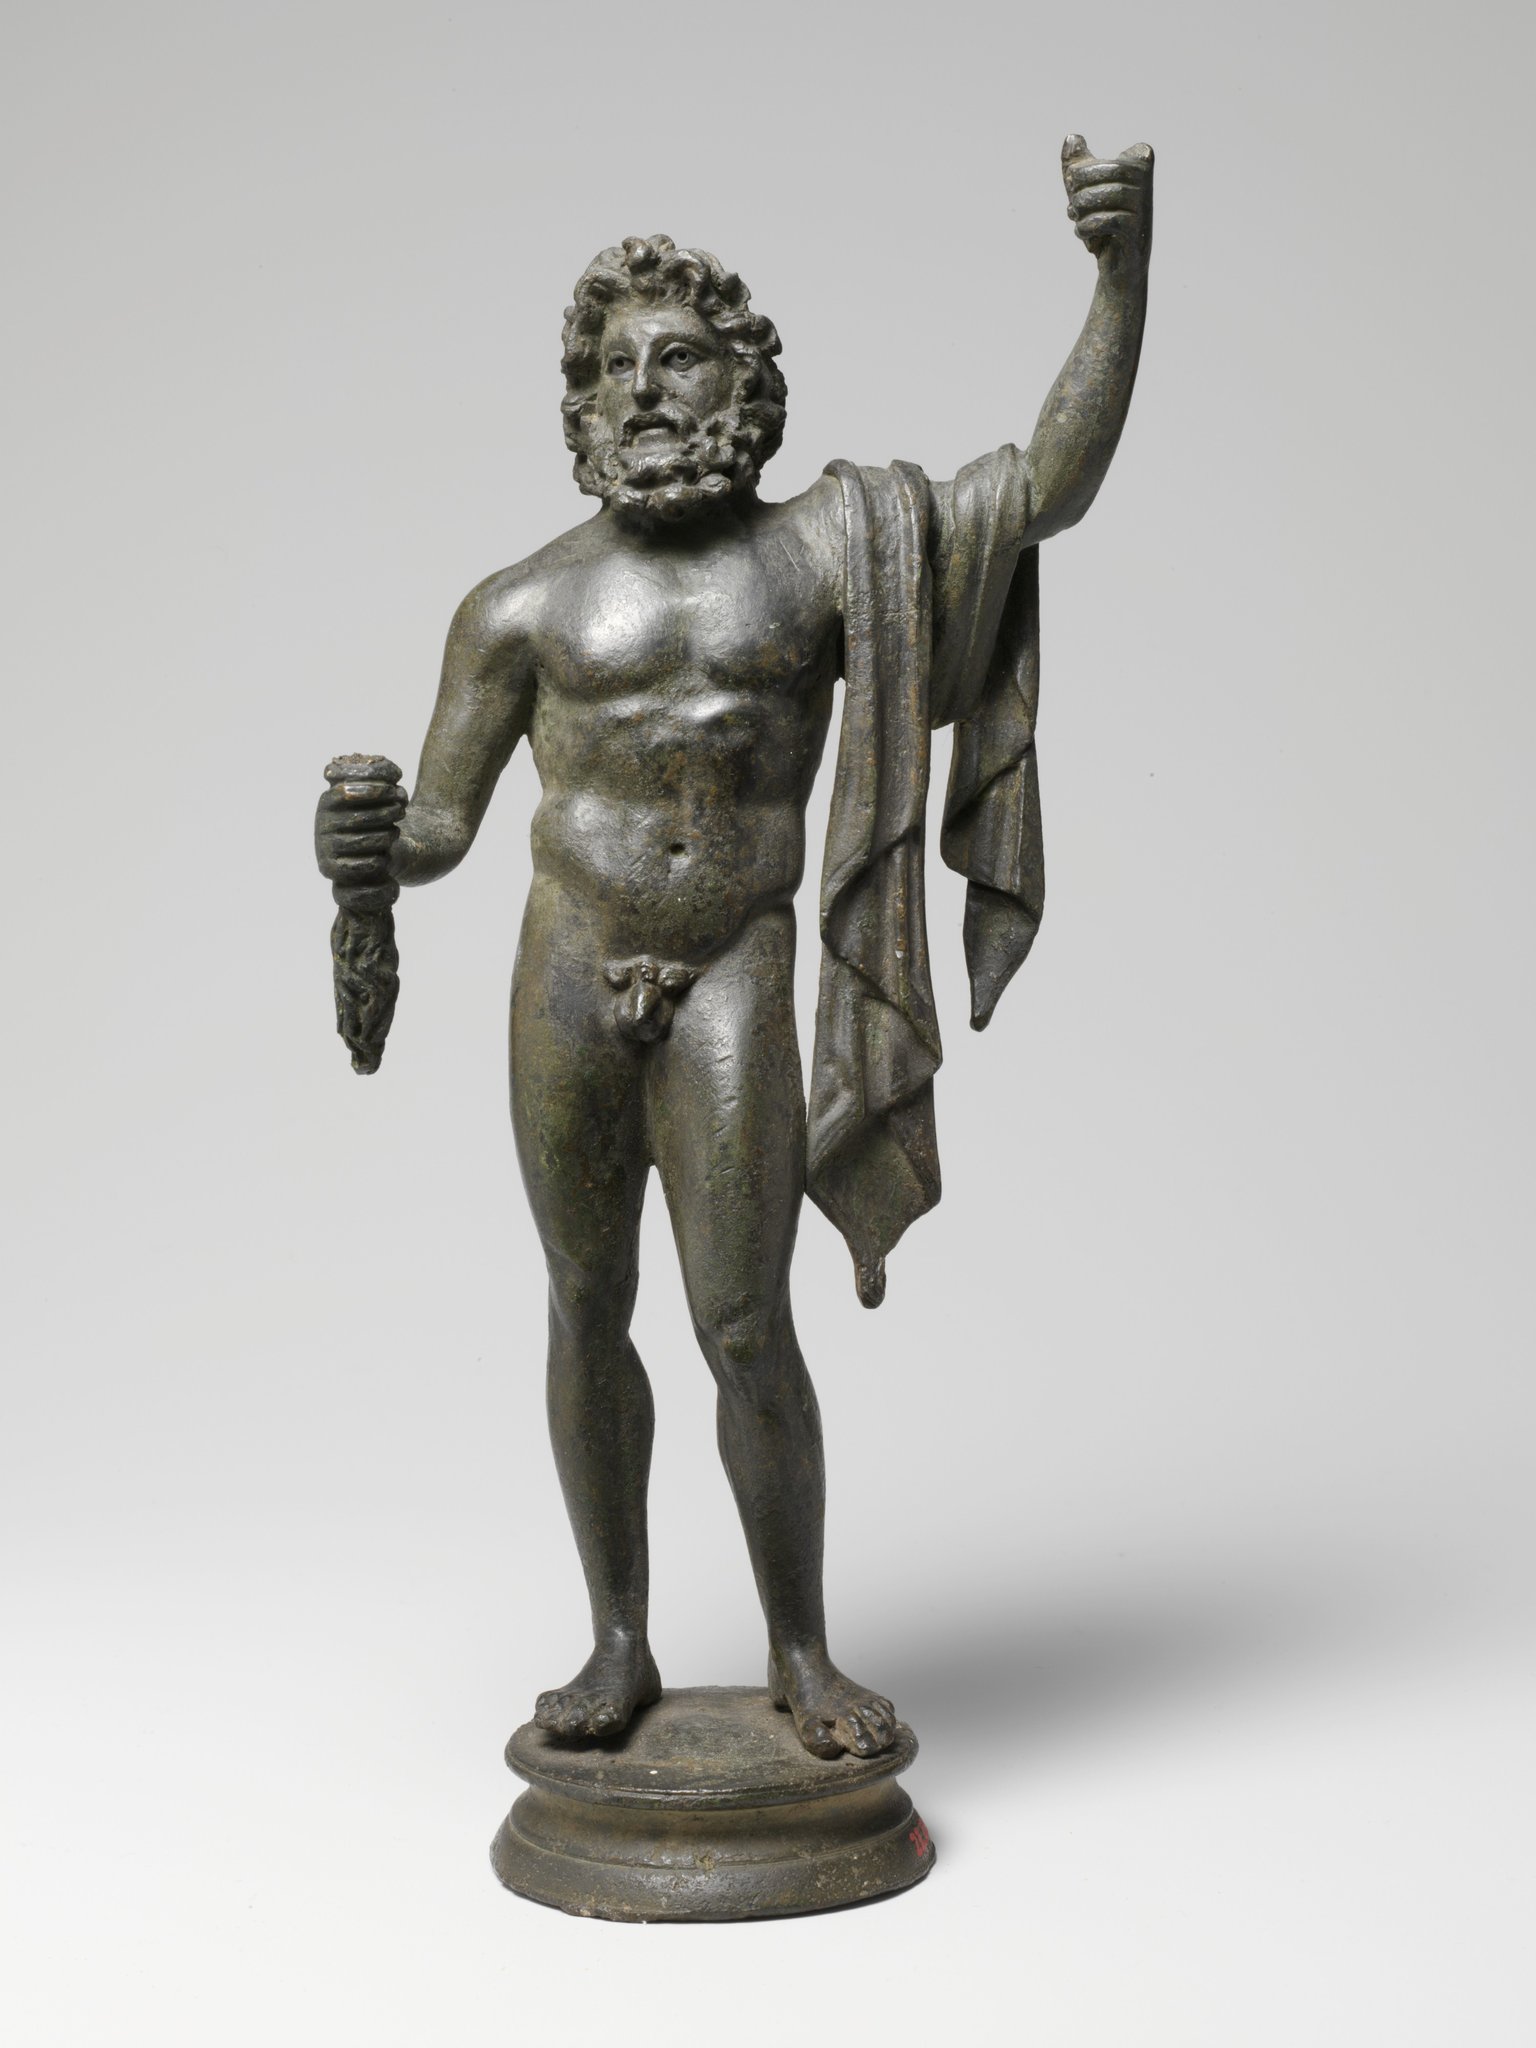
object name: statuette of zeus ammon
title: Bronze statuette of Jupiter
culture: roman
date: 67-100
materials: bronze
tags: male nudes,jupiter